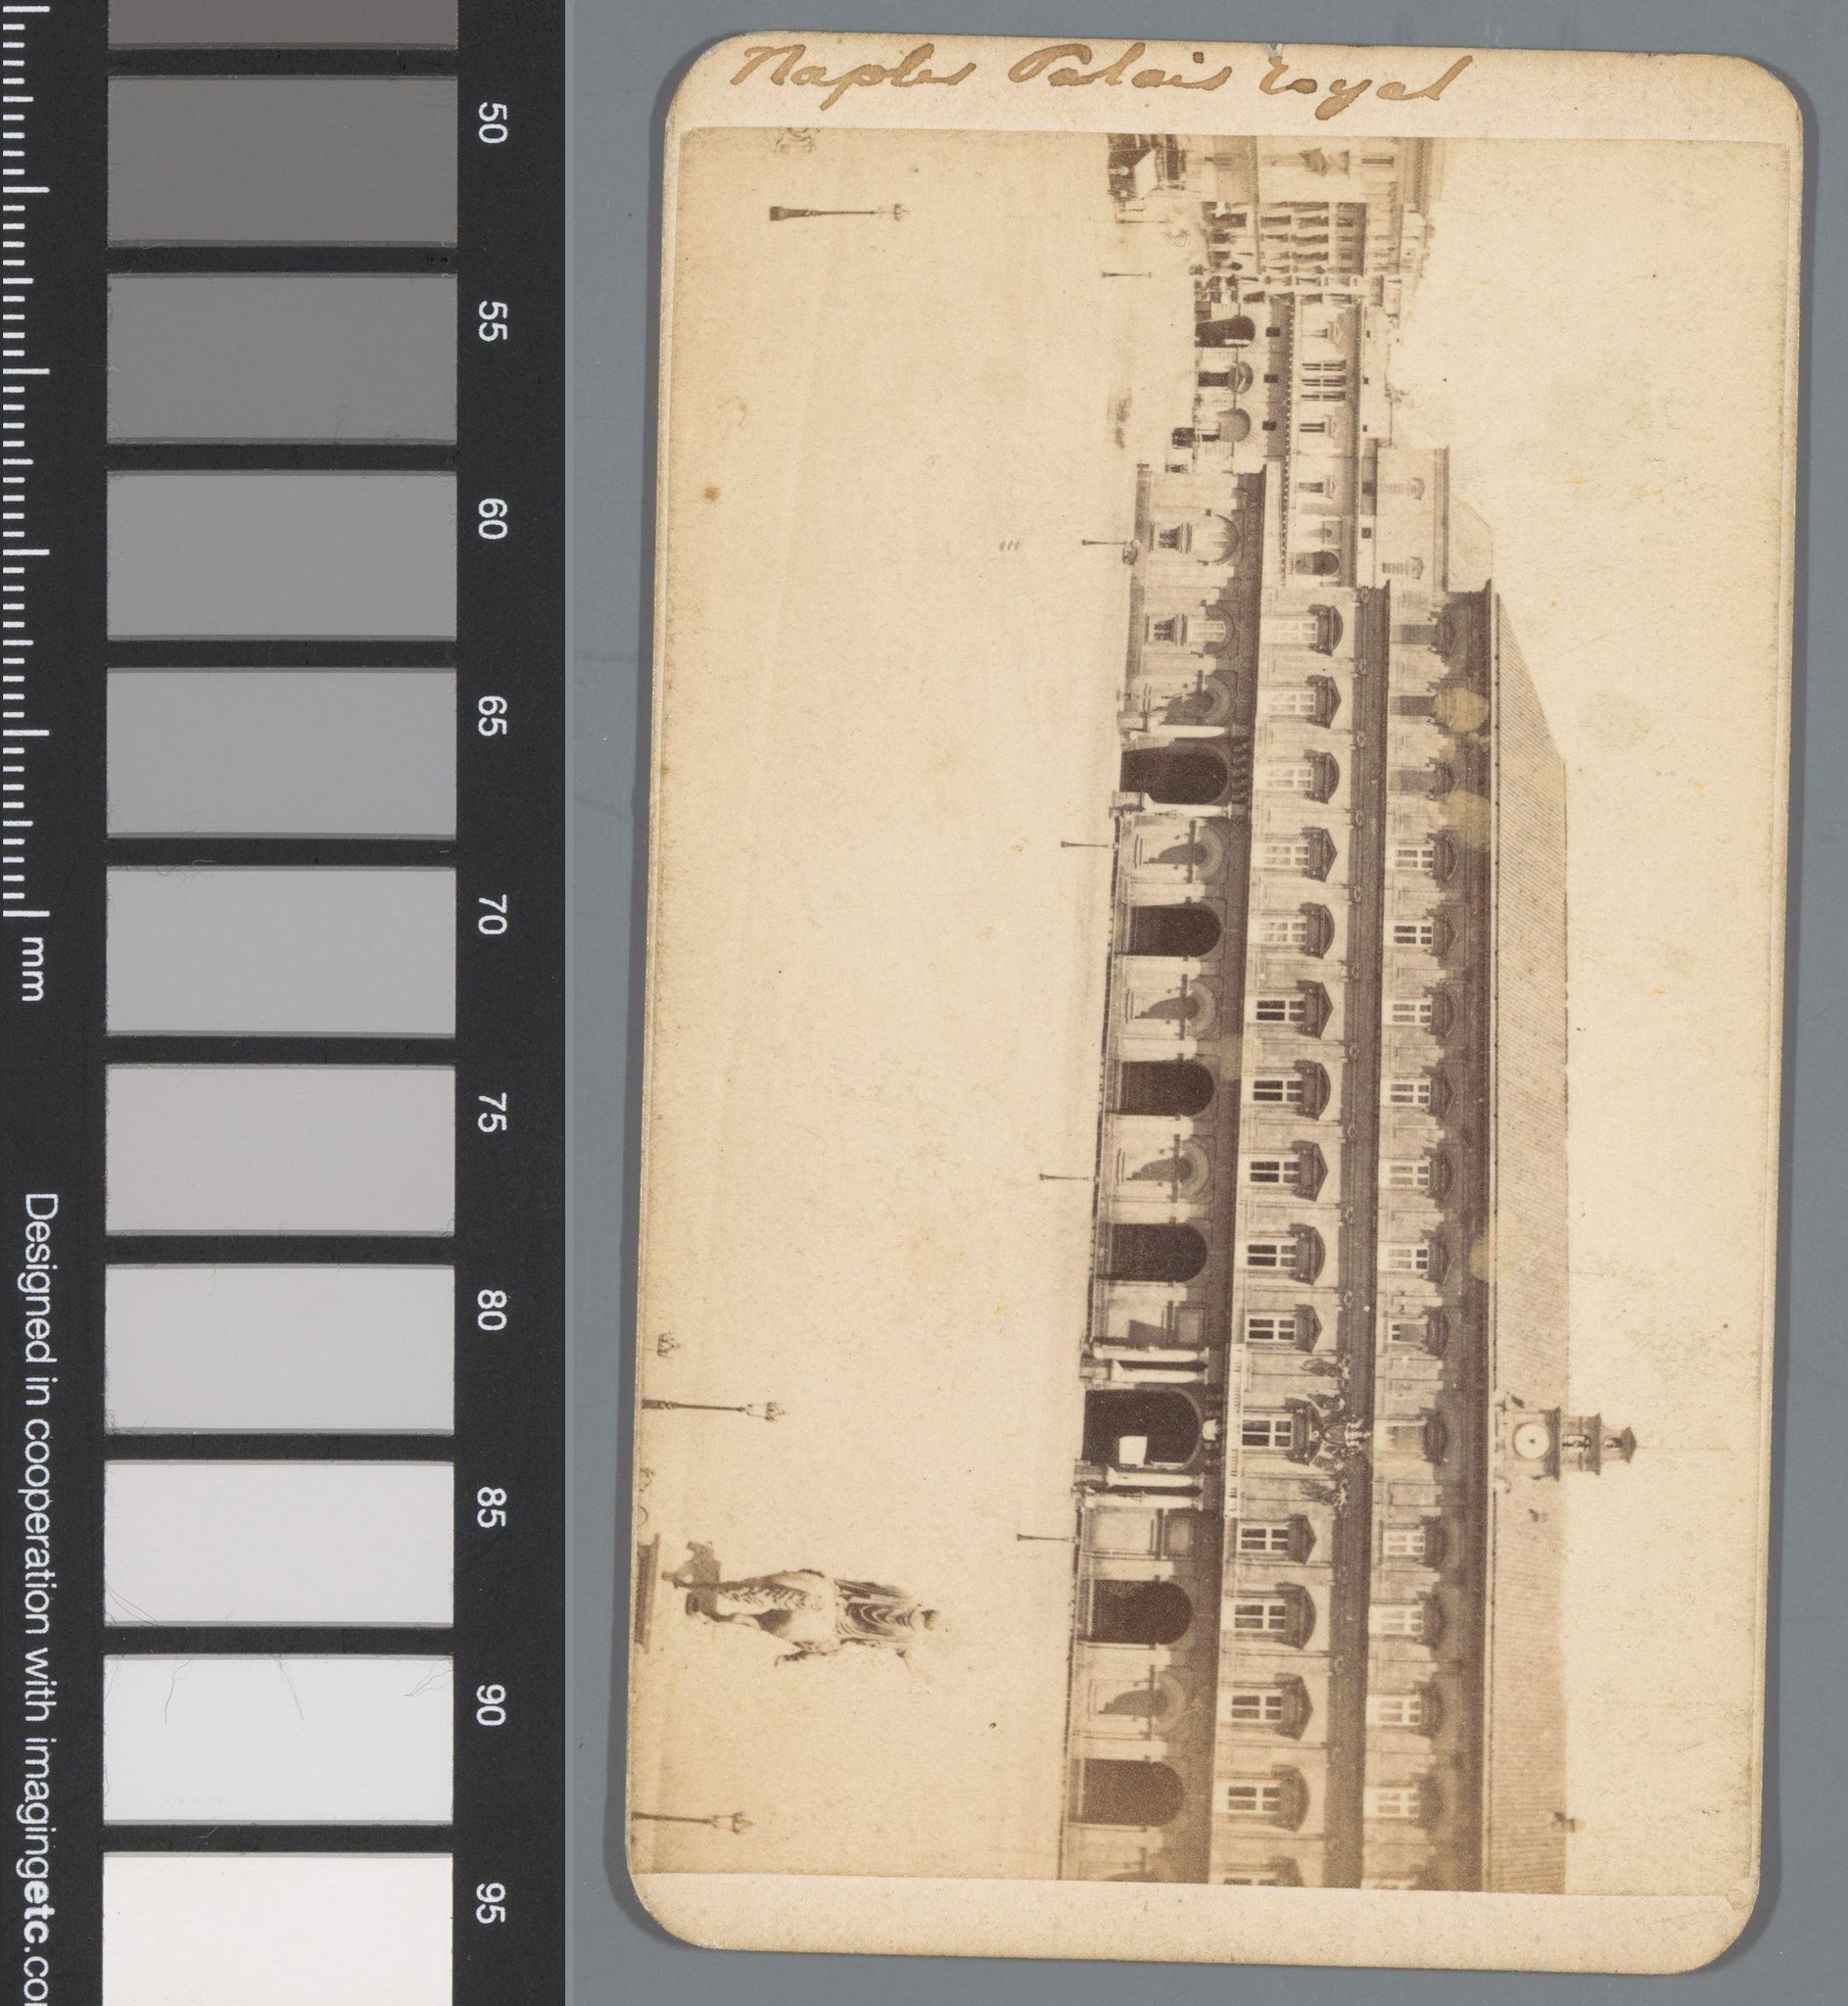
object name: photograph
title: Naples, Palais royal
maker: Anonymous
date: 1855-1885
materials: cardboard, paper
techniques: albumen print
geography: naples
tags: square, place, circus, etc., palace